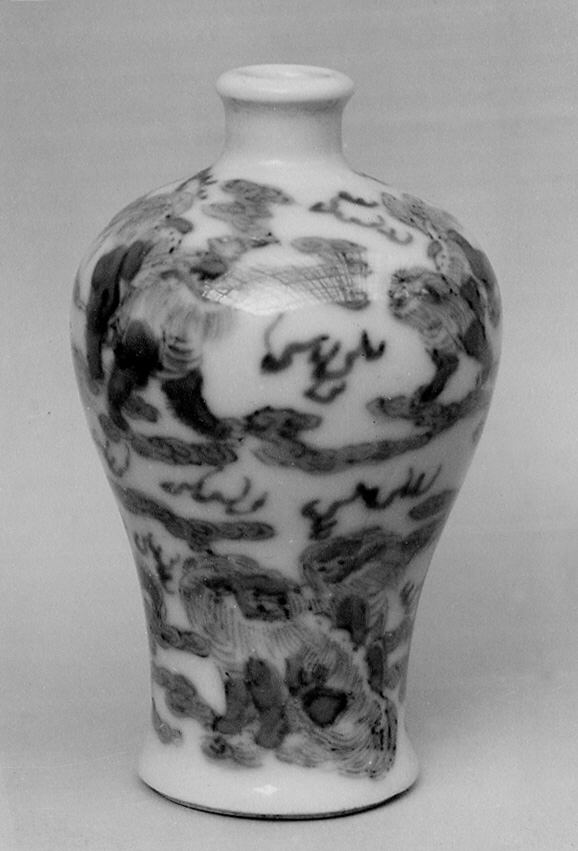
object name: snuff bottle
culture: chinese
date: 1723-1735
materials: porcelain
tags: mythical creatures